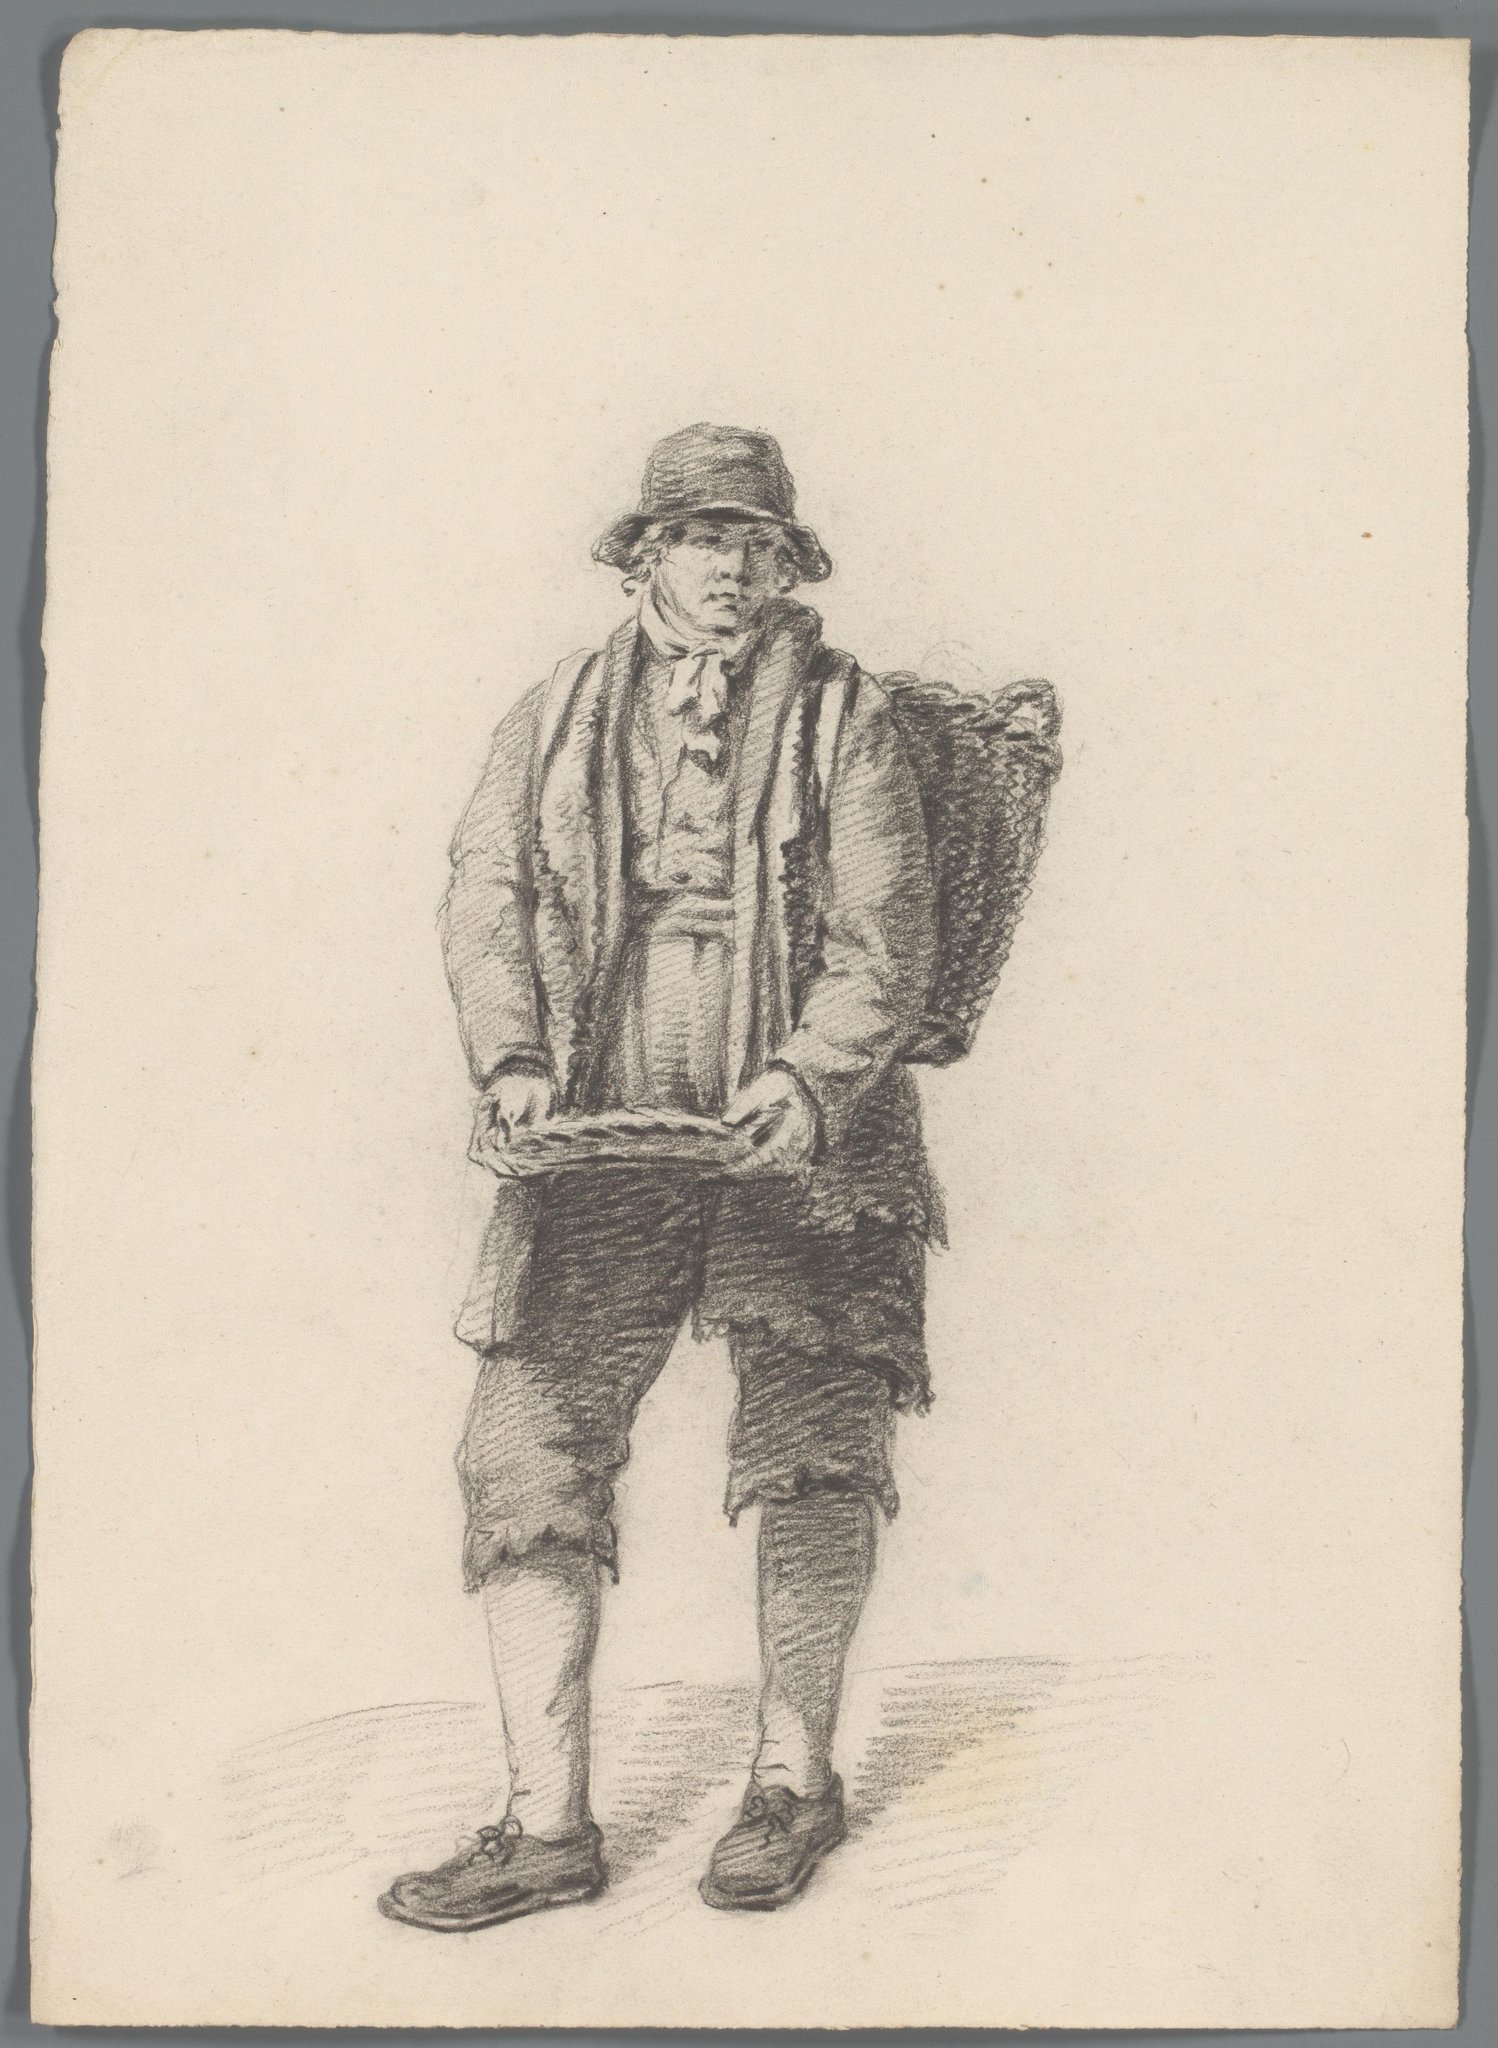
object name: drawing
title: Man met een mand op zijn rug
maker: Anonymous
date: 1820-1830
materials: chalk, paper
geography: the hague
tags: adult man, container made of plant material other than wood: basket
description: Tekeningen waarschijnlijk ontstaan bij het Haagse kunstgenootschap ‘Tot Nut der Tekenkunst’, waar twee keer per week tekenavonden werden georganiseerd met geklede modellen.